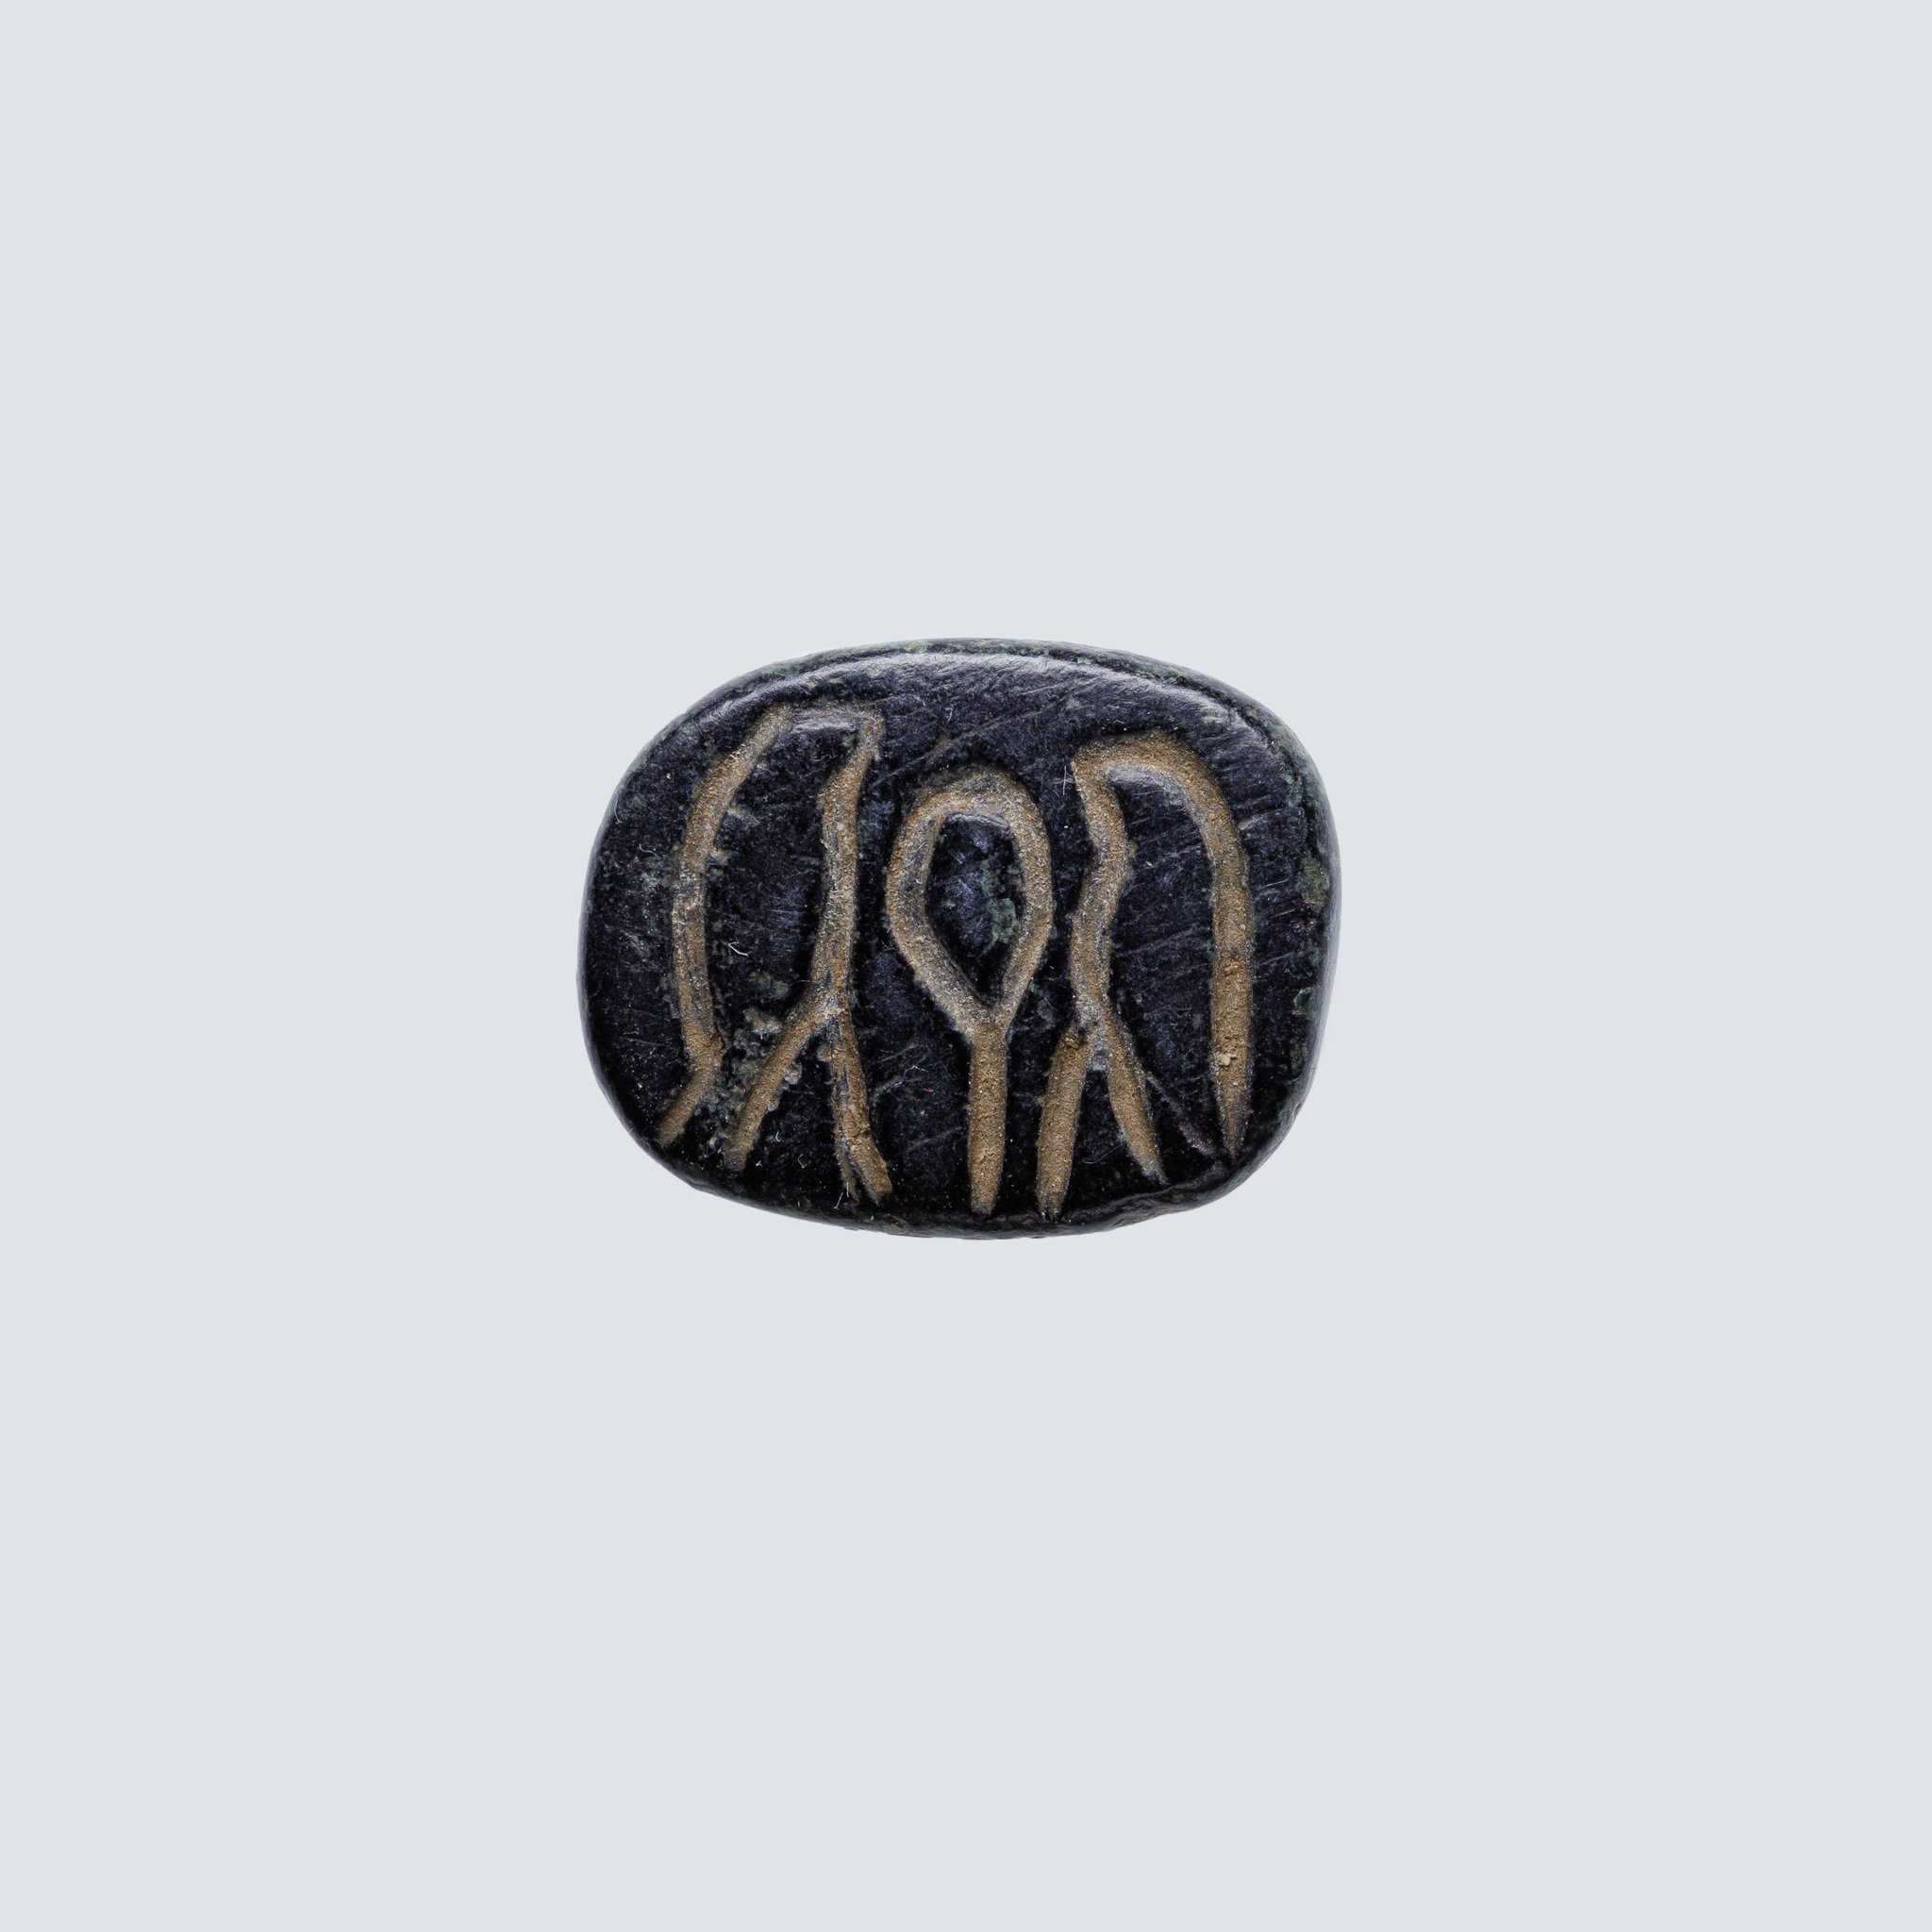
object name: design amulet, two falcon, ankh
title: Design Amulet, Pyramidal Back with Horizontal Piercing, Device showing Two Falcons Flanking what is meant to be an Ankh Sign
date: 2150-2010 BCE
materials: stone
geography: egypt